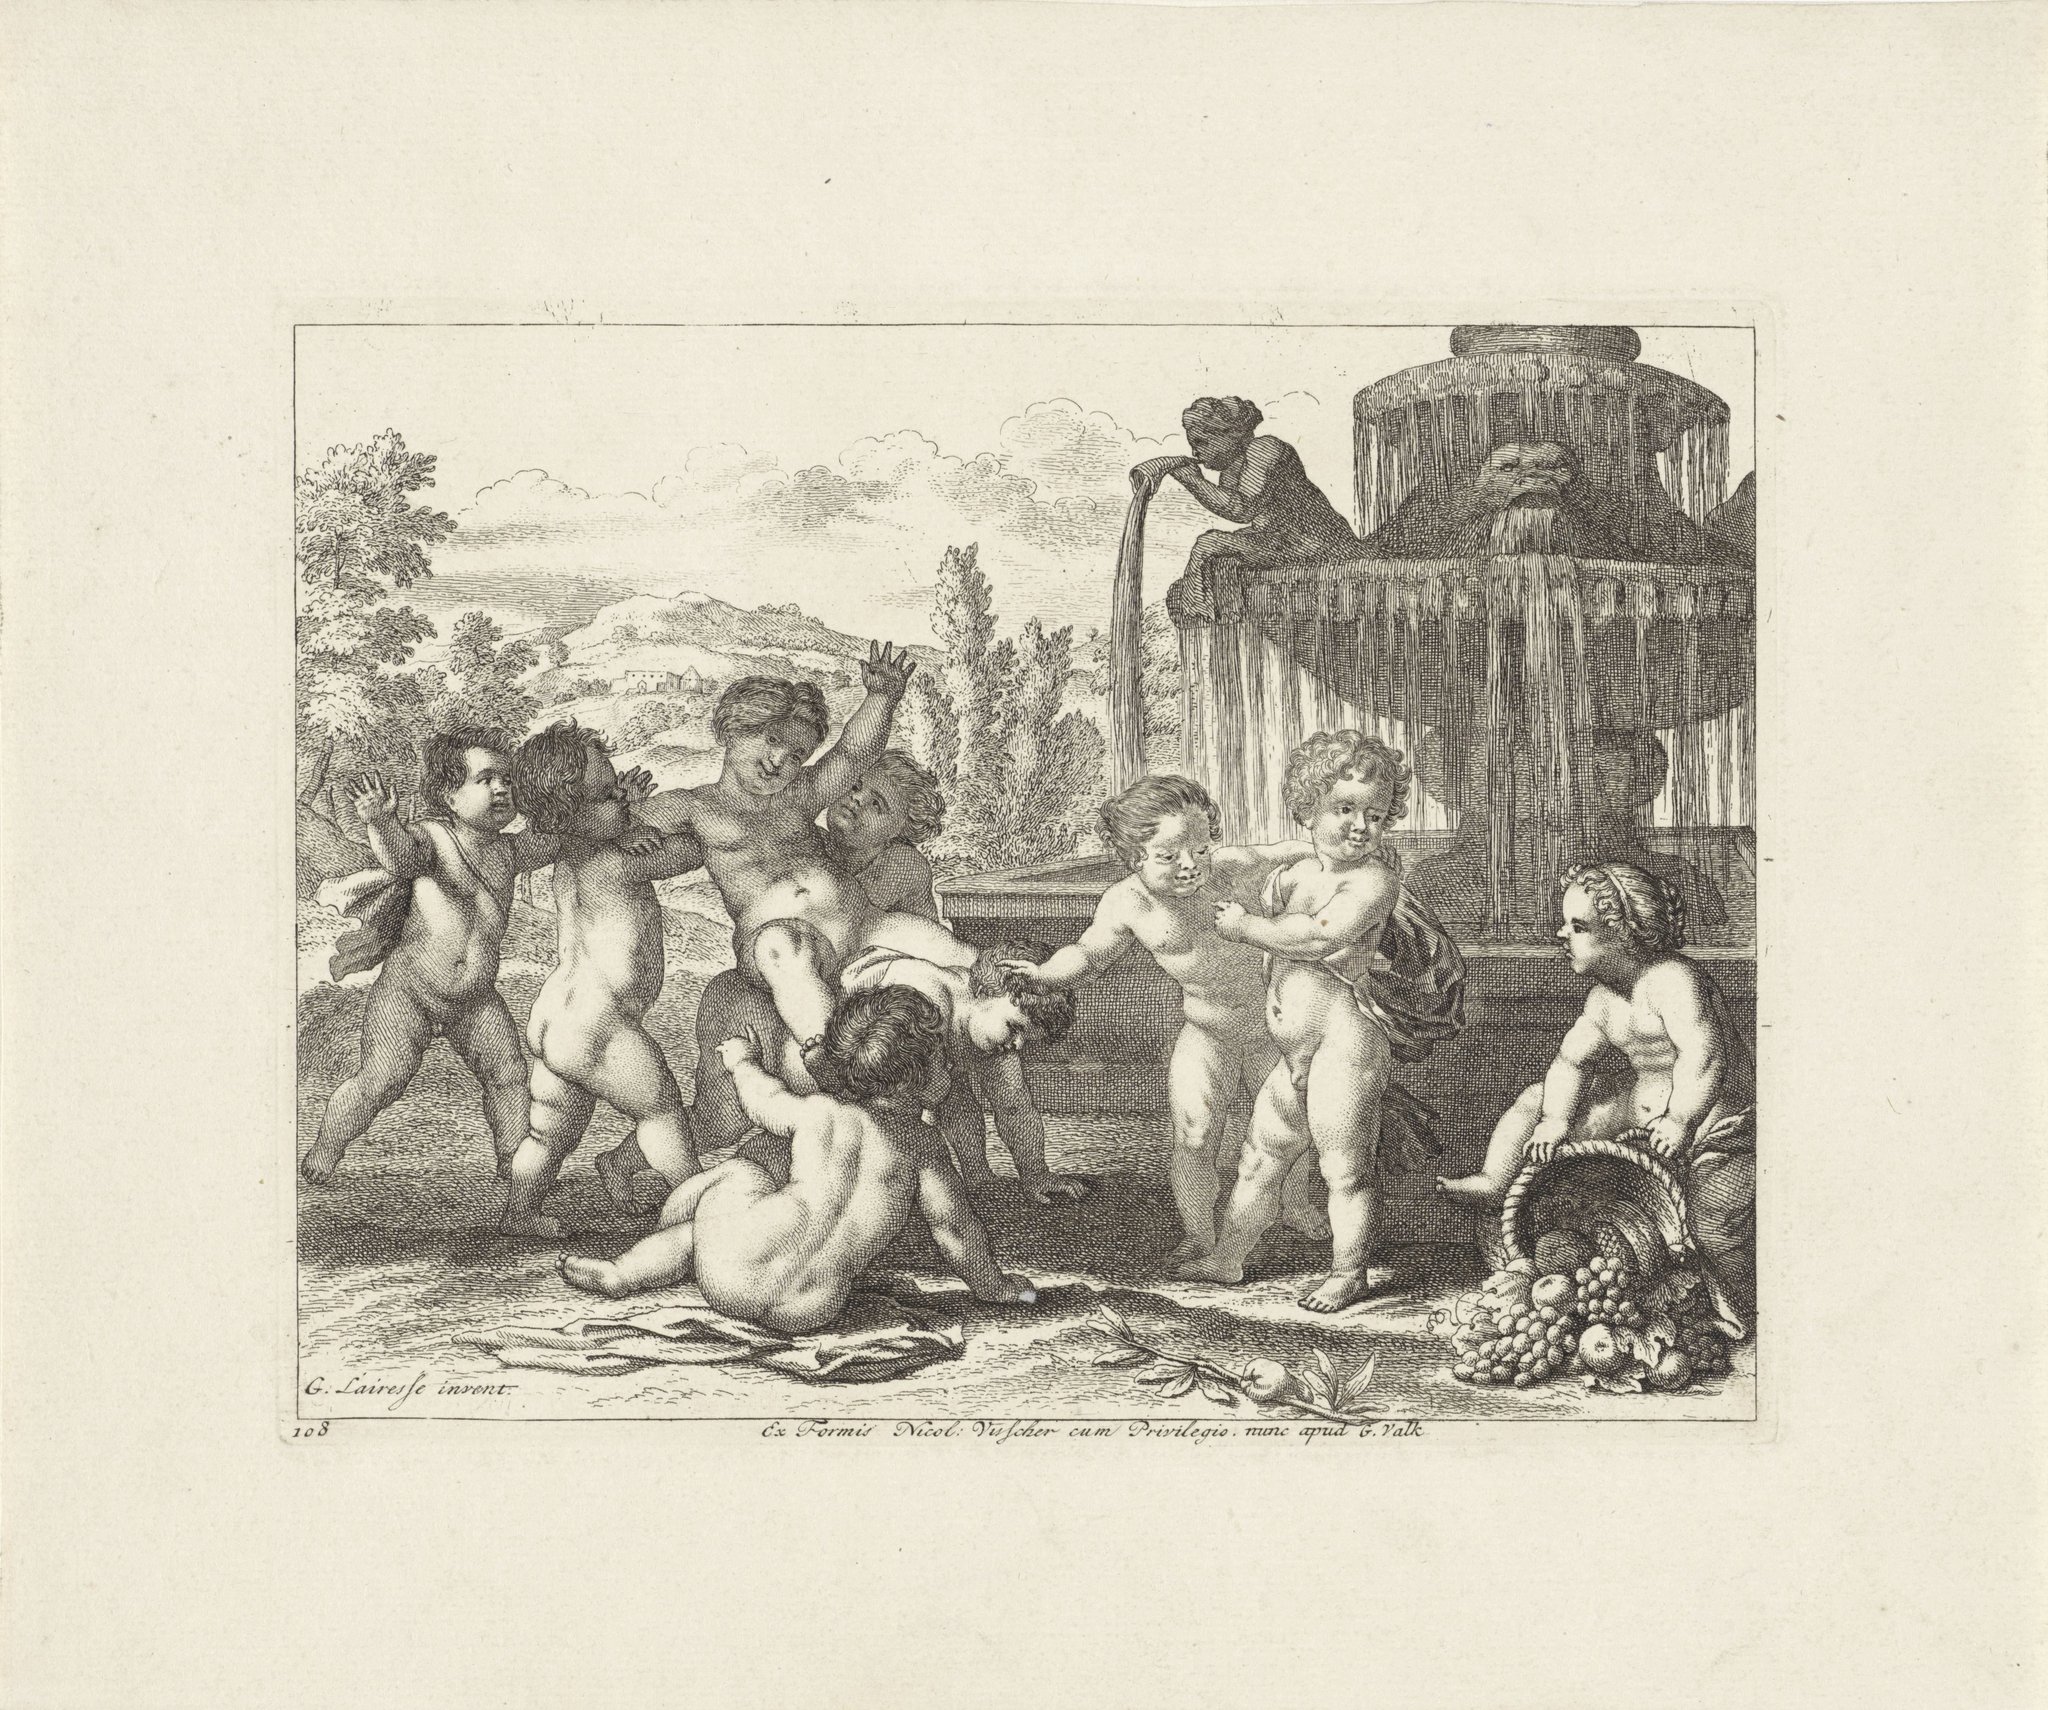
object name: print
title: Putti bij een fontein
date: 1670-1700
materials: paper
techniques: etching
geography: amsterdam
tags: garden fountain, cupids: 'amores', 'amoretti', 'putti'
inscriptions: collector's mark: Lugt 2228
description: Bij een fontein in een heuvelachtig landschap spelen negen putti. Rechtsvoor zit een putto op een omgevallen fruitmand. Linksonder: 108.